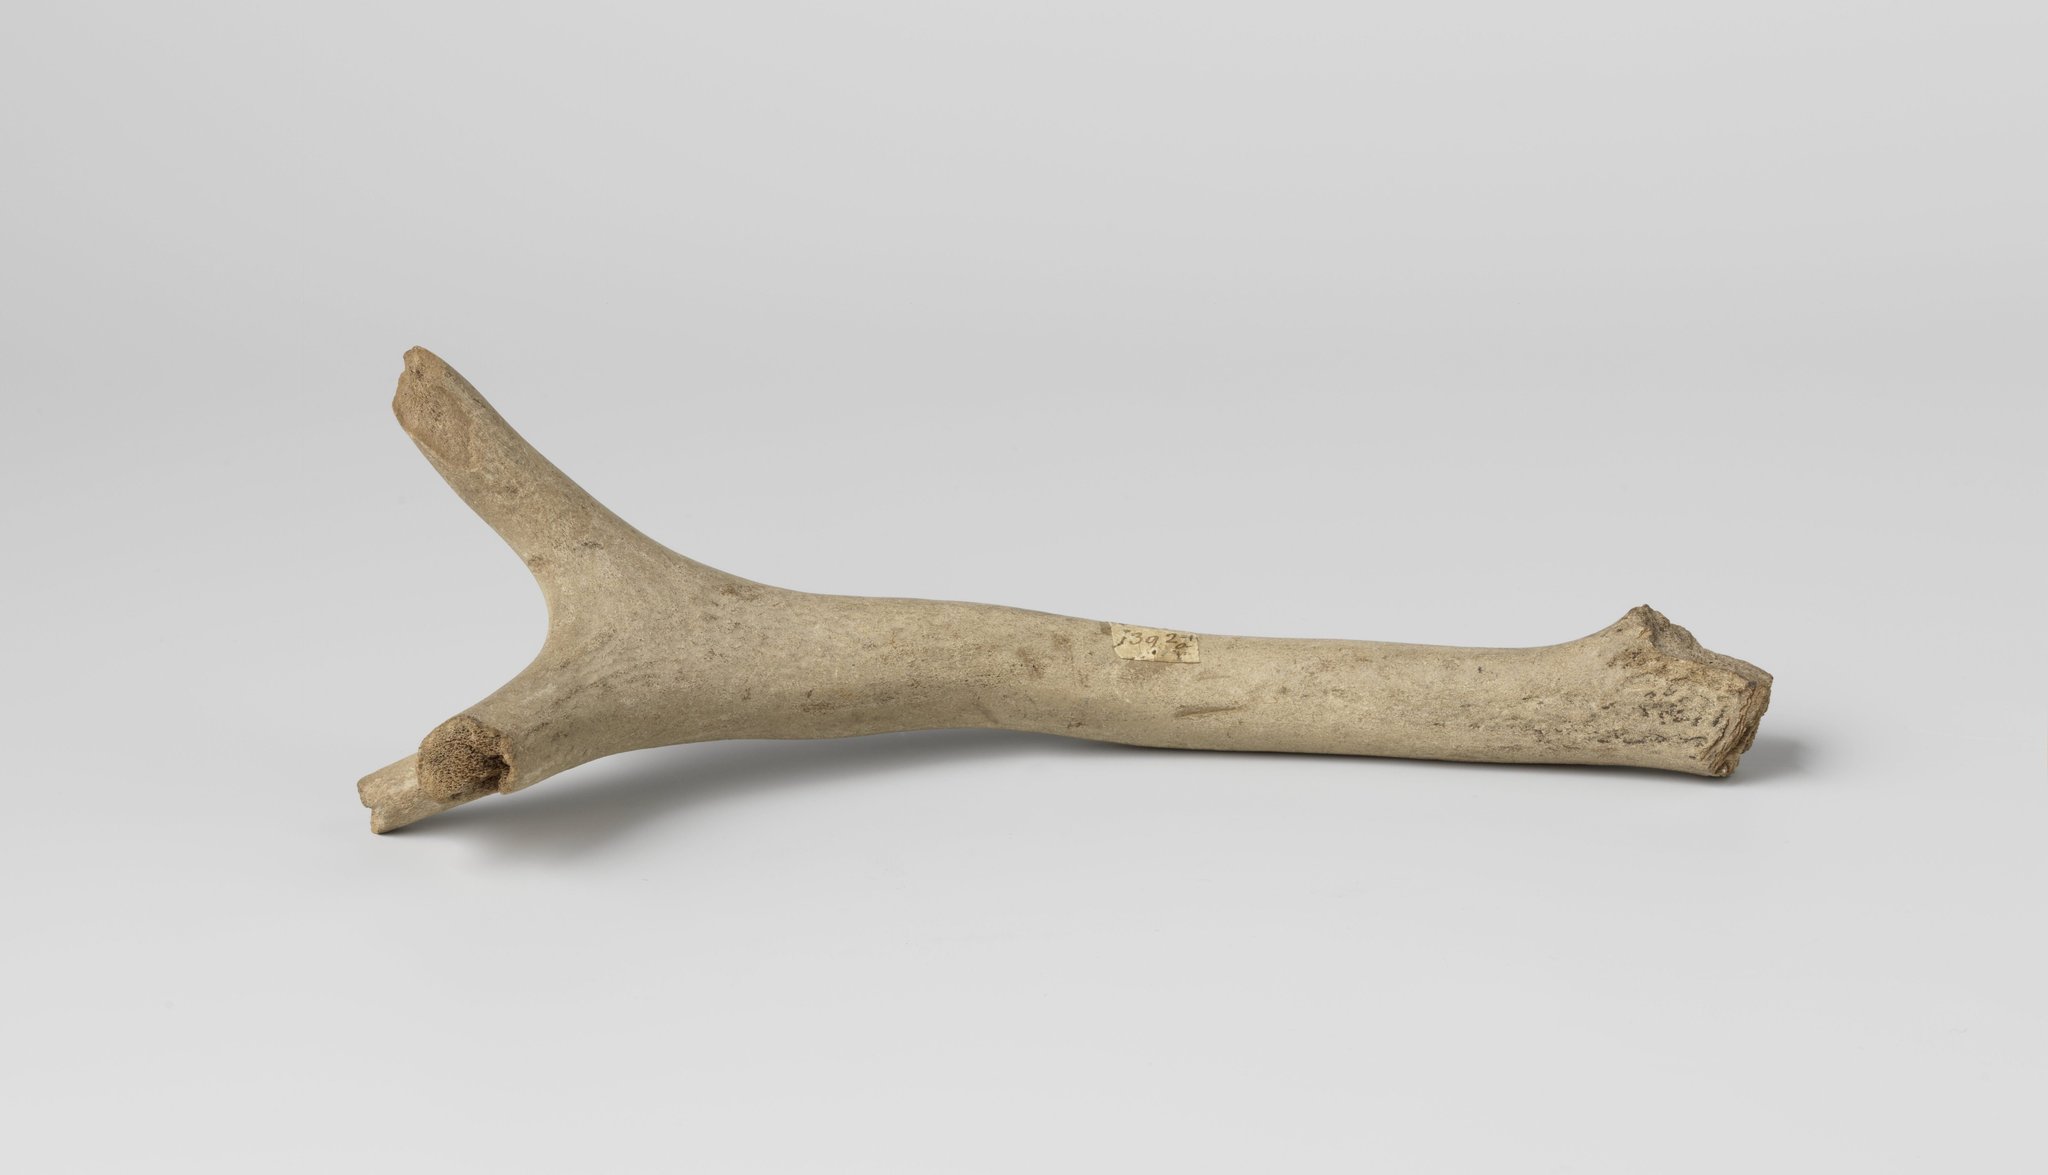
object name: hertengewei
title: Stang van een gewei van een hert, gevonden in 1724 bij werkzaamheden in de Hillegommerbeek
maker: Anonymous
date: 1724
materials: horn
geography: netherlands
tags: hillegom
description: Behorend tot drie hertshoornen en twee slagtanden van een wild zwijn (NG-NM-1392-1 t/m NG-NM-1392-5).